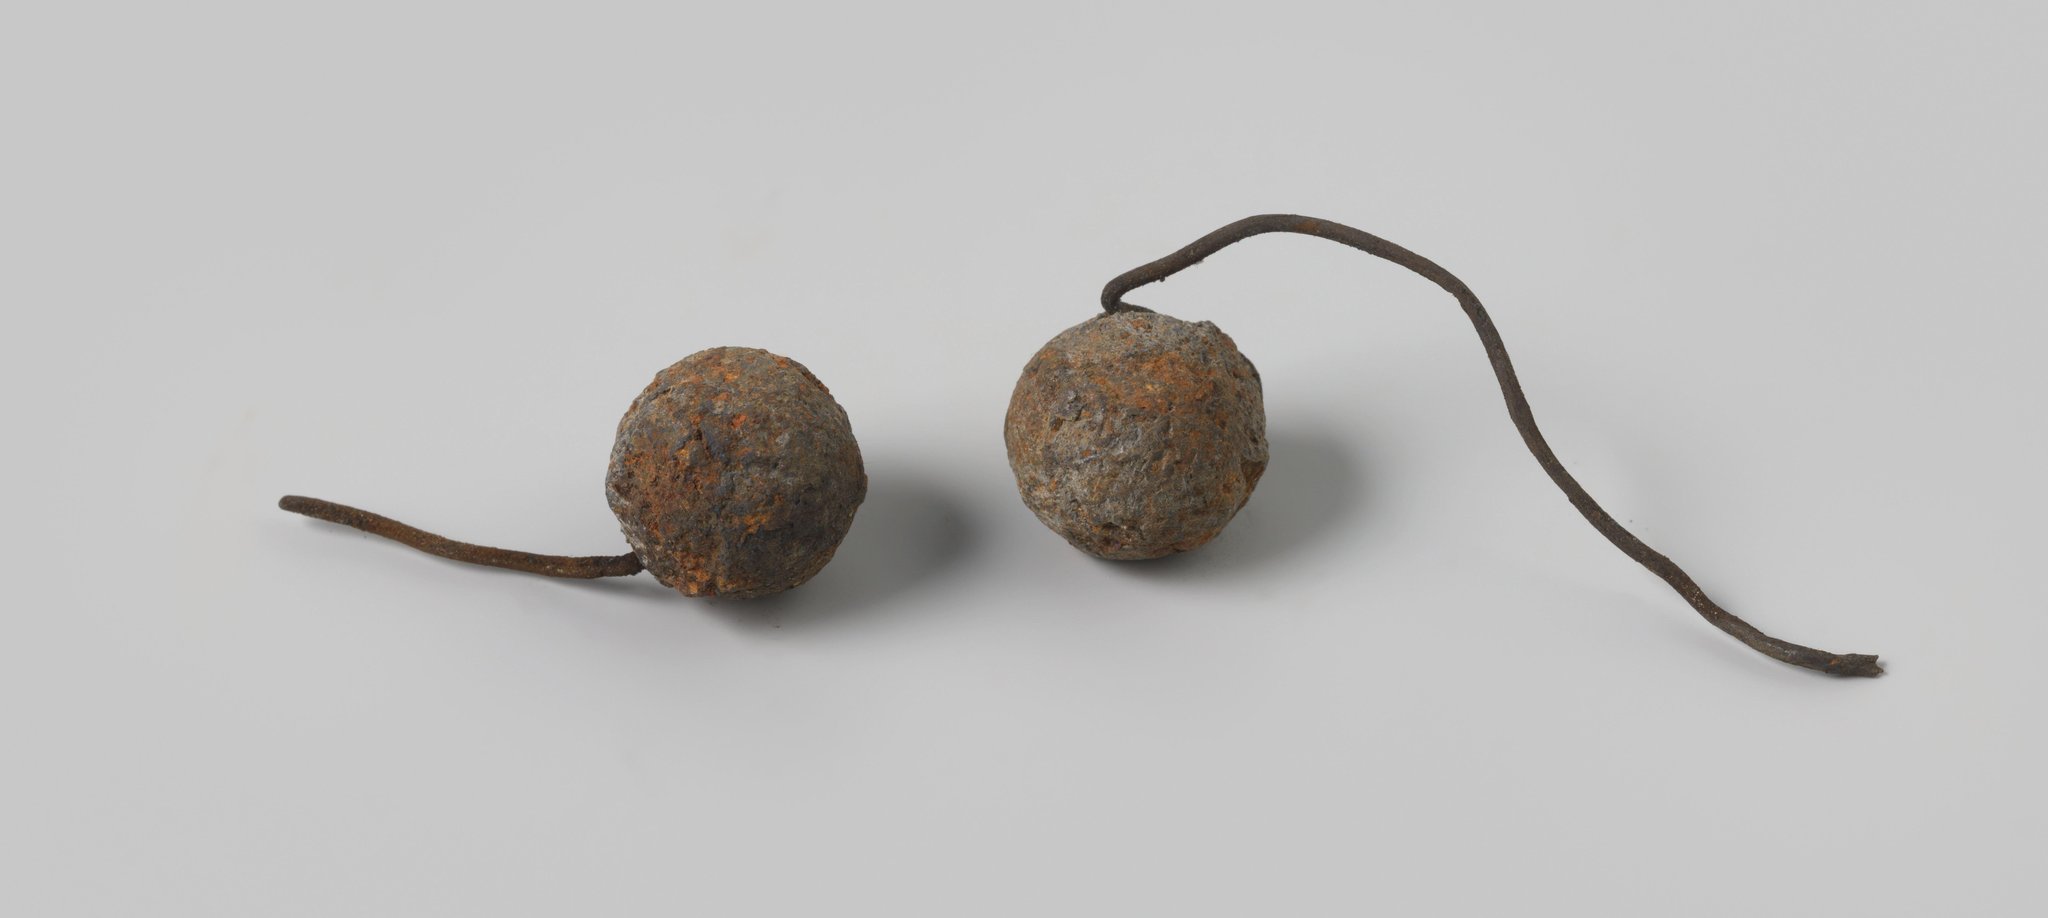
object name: chain shot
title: Kettingkogels uit het wrak van de Oost-Indiëvaarder Hollandia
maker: Anonymous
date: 1700-1743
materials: lead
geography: netherlands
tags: verenigde oostindische compagnie, hollandia (schip), annet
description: Shot, springshot; fragment single balls with wire, id. NG 1980-27H3168.